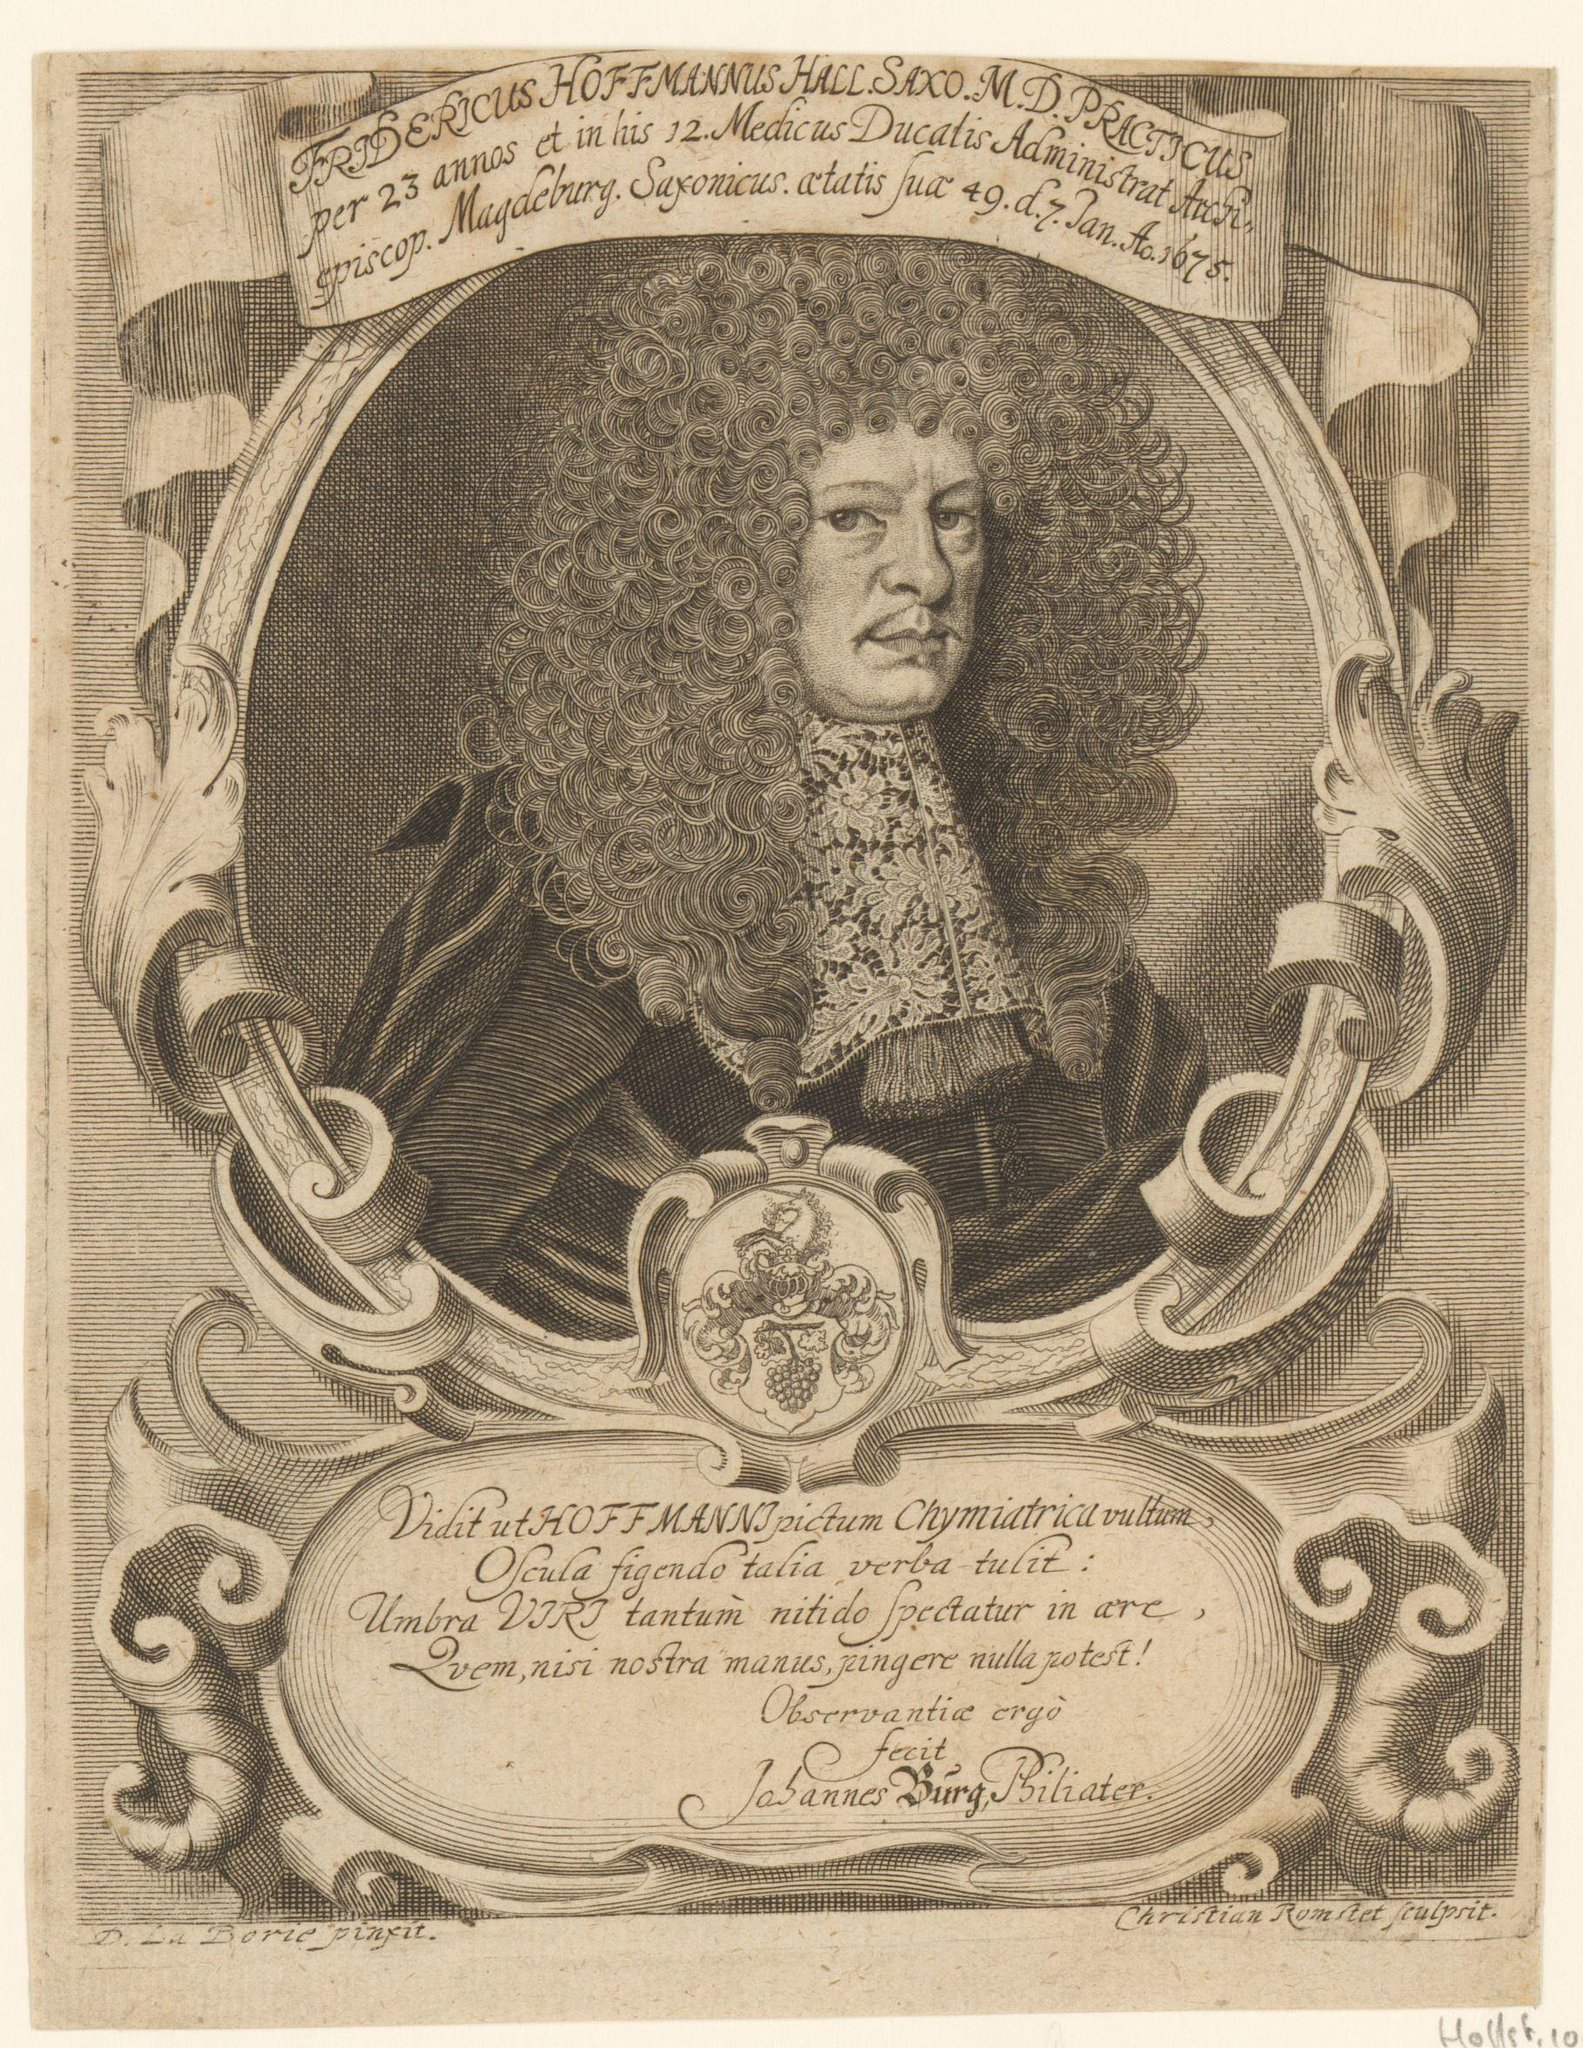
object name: print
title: Portret van Friedrich Hoffmann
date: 1665-1721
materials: paper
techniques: engraving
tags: theologian, historical persons, armorial bearing, heraldry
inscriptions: collector's mark: Lugt 2228